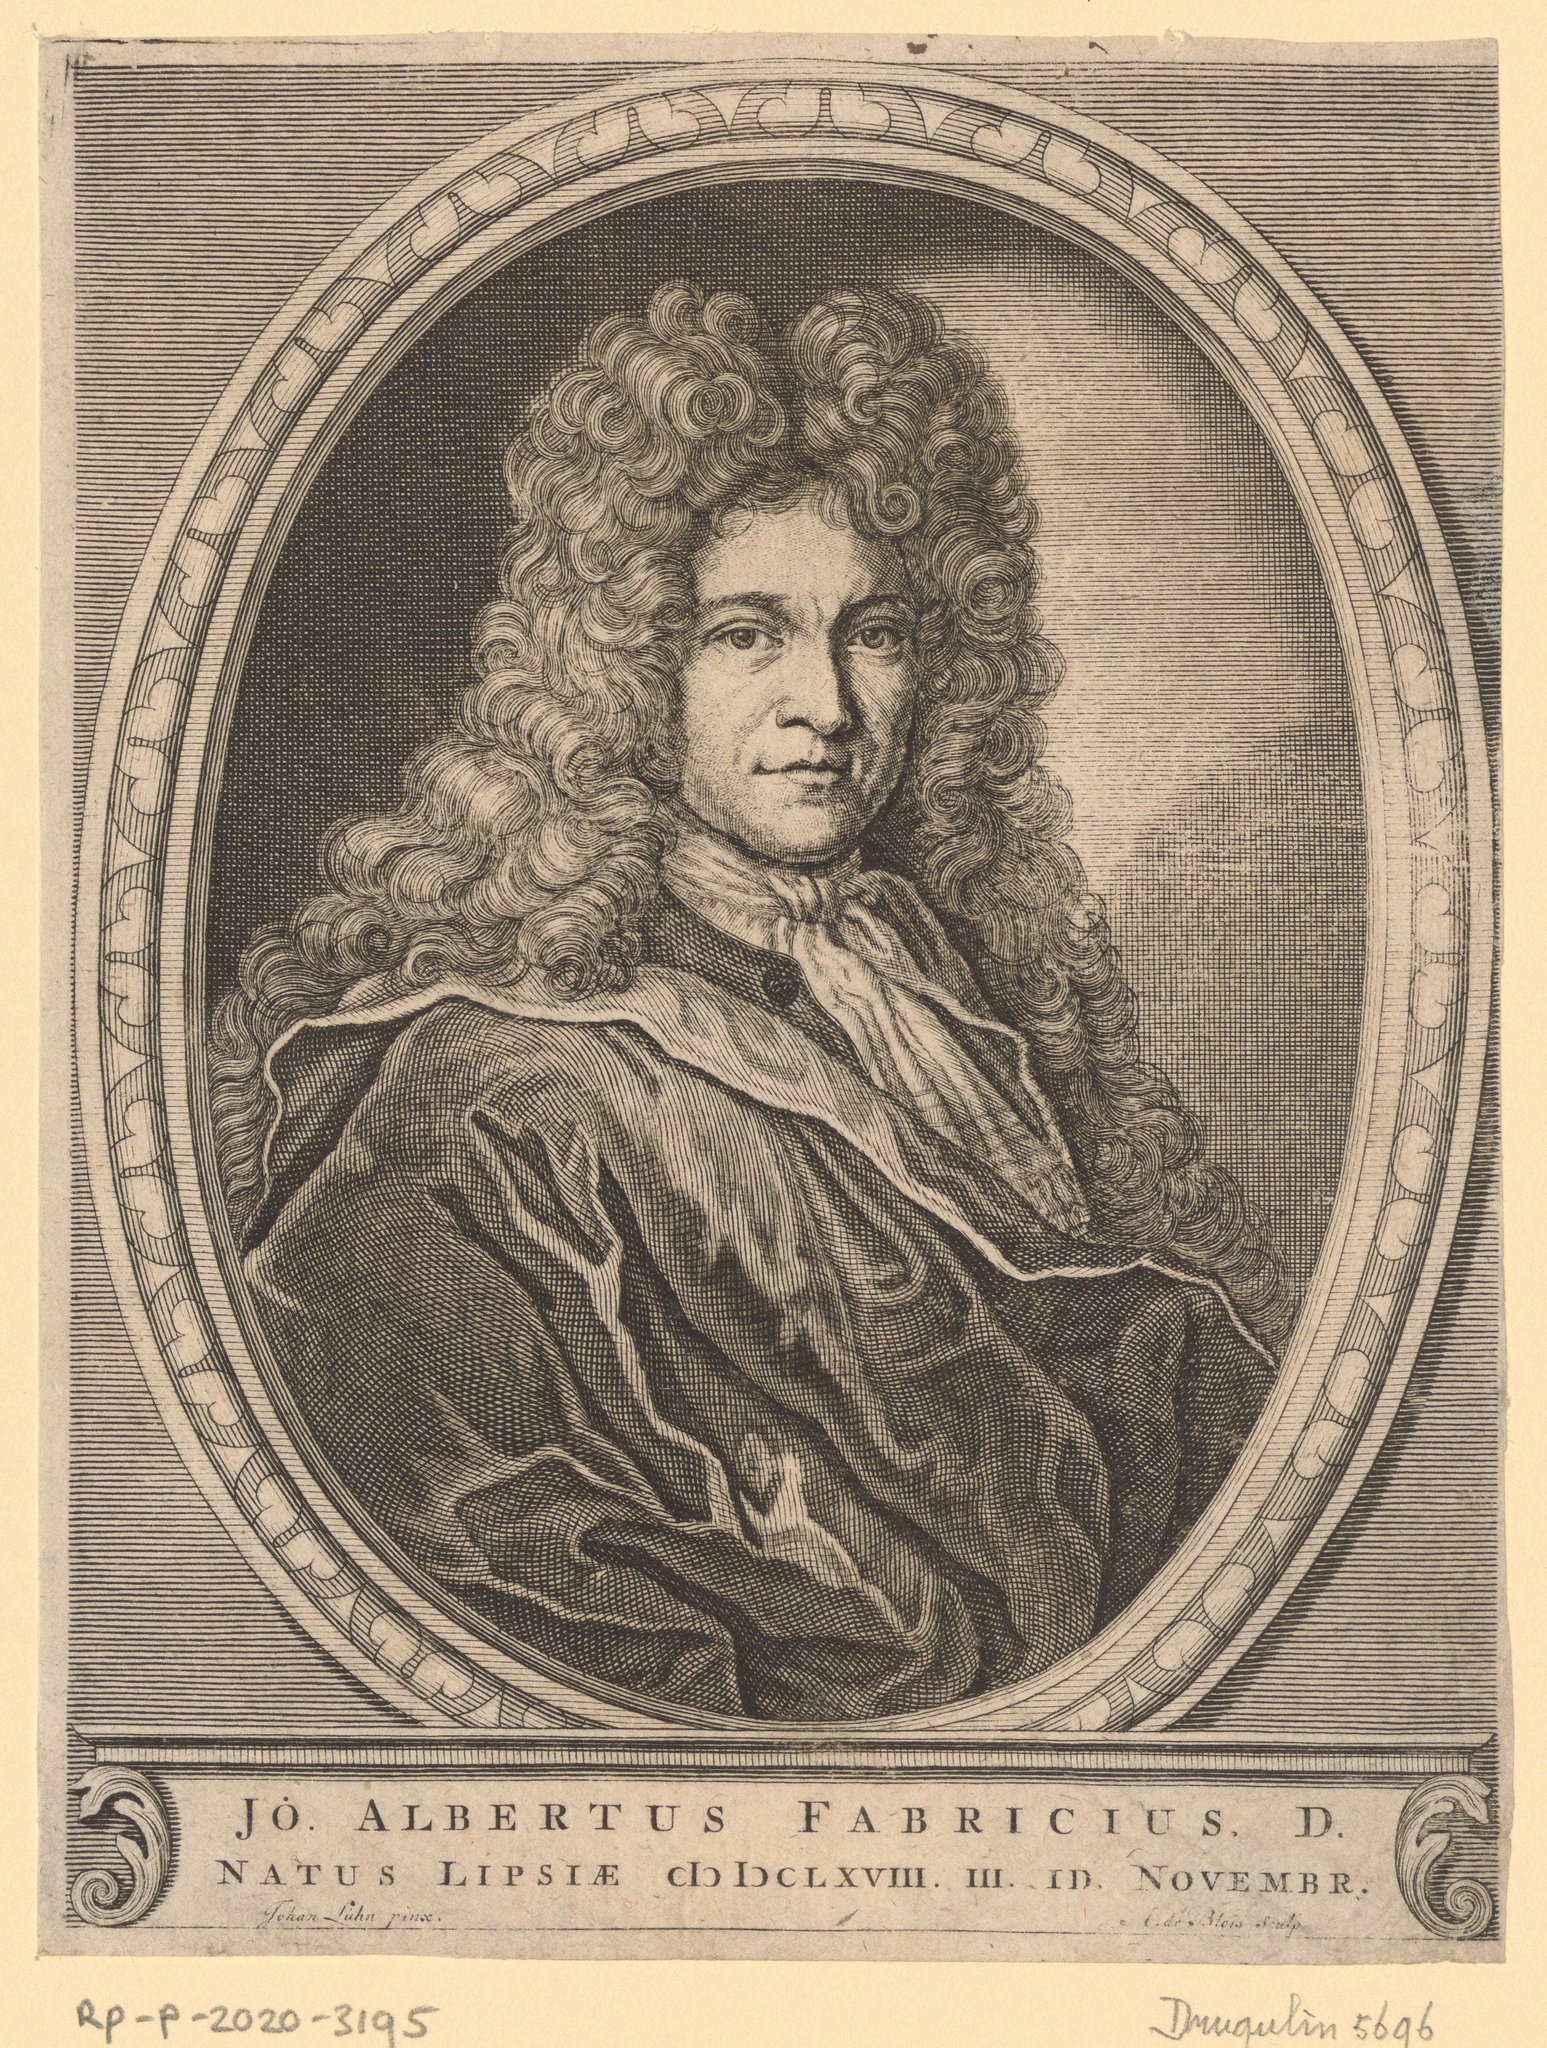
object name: print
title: Portret van Johann Albert Fabricius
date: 1690-1717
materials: paper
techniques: engraving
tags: johann albert fabricius, historical persons, portrait of a writer